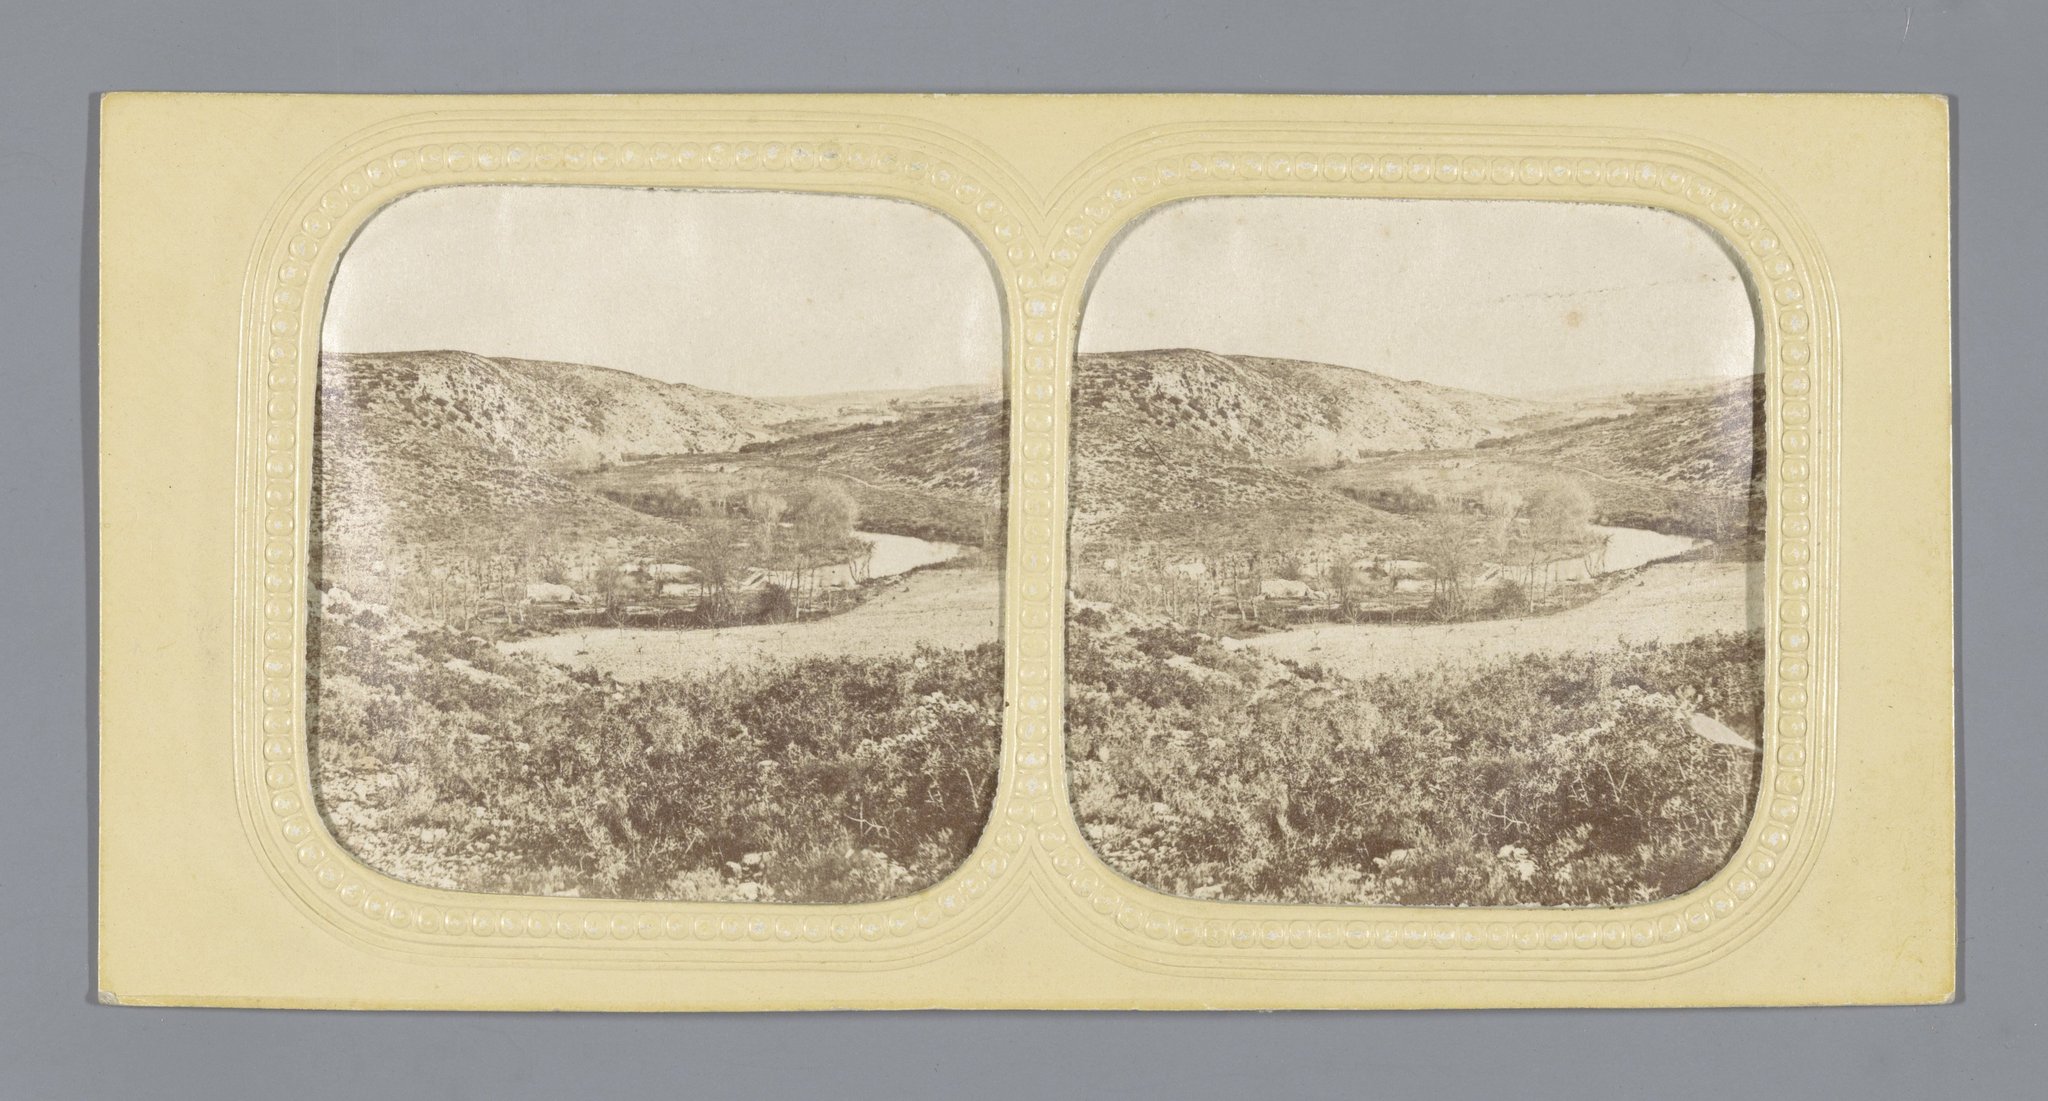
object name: tissue stereograph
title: Les Cevenes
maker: Anonymous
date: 1855-1875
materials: cardboard, paper, photographic support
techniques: albumen print, hand coloring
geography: cévennes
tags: low hill country, forest, wood, brook